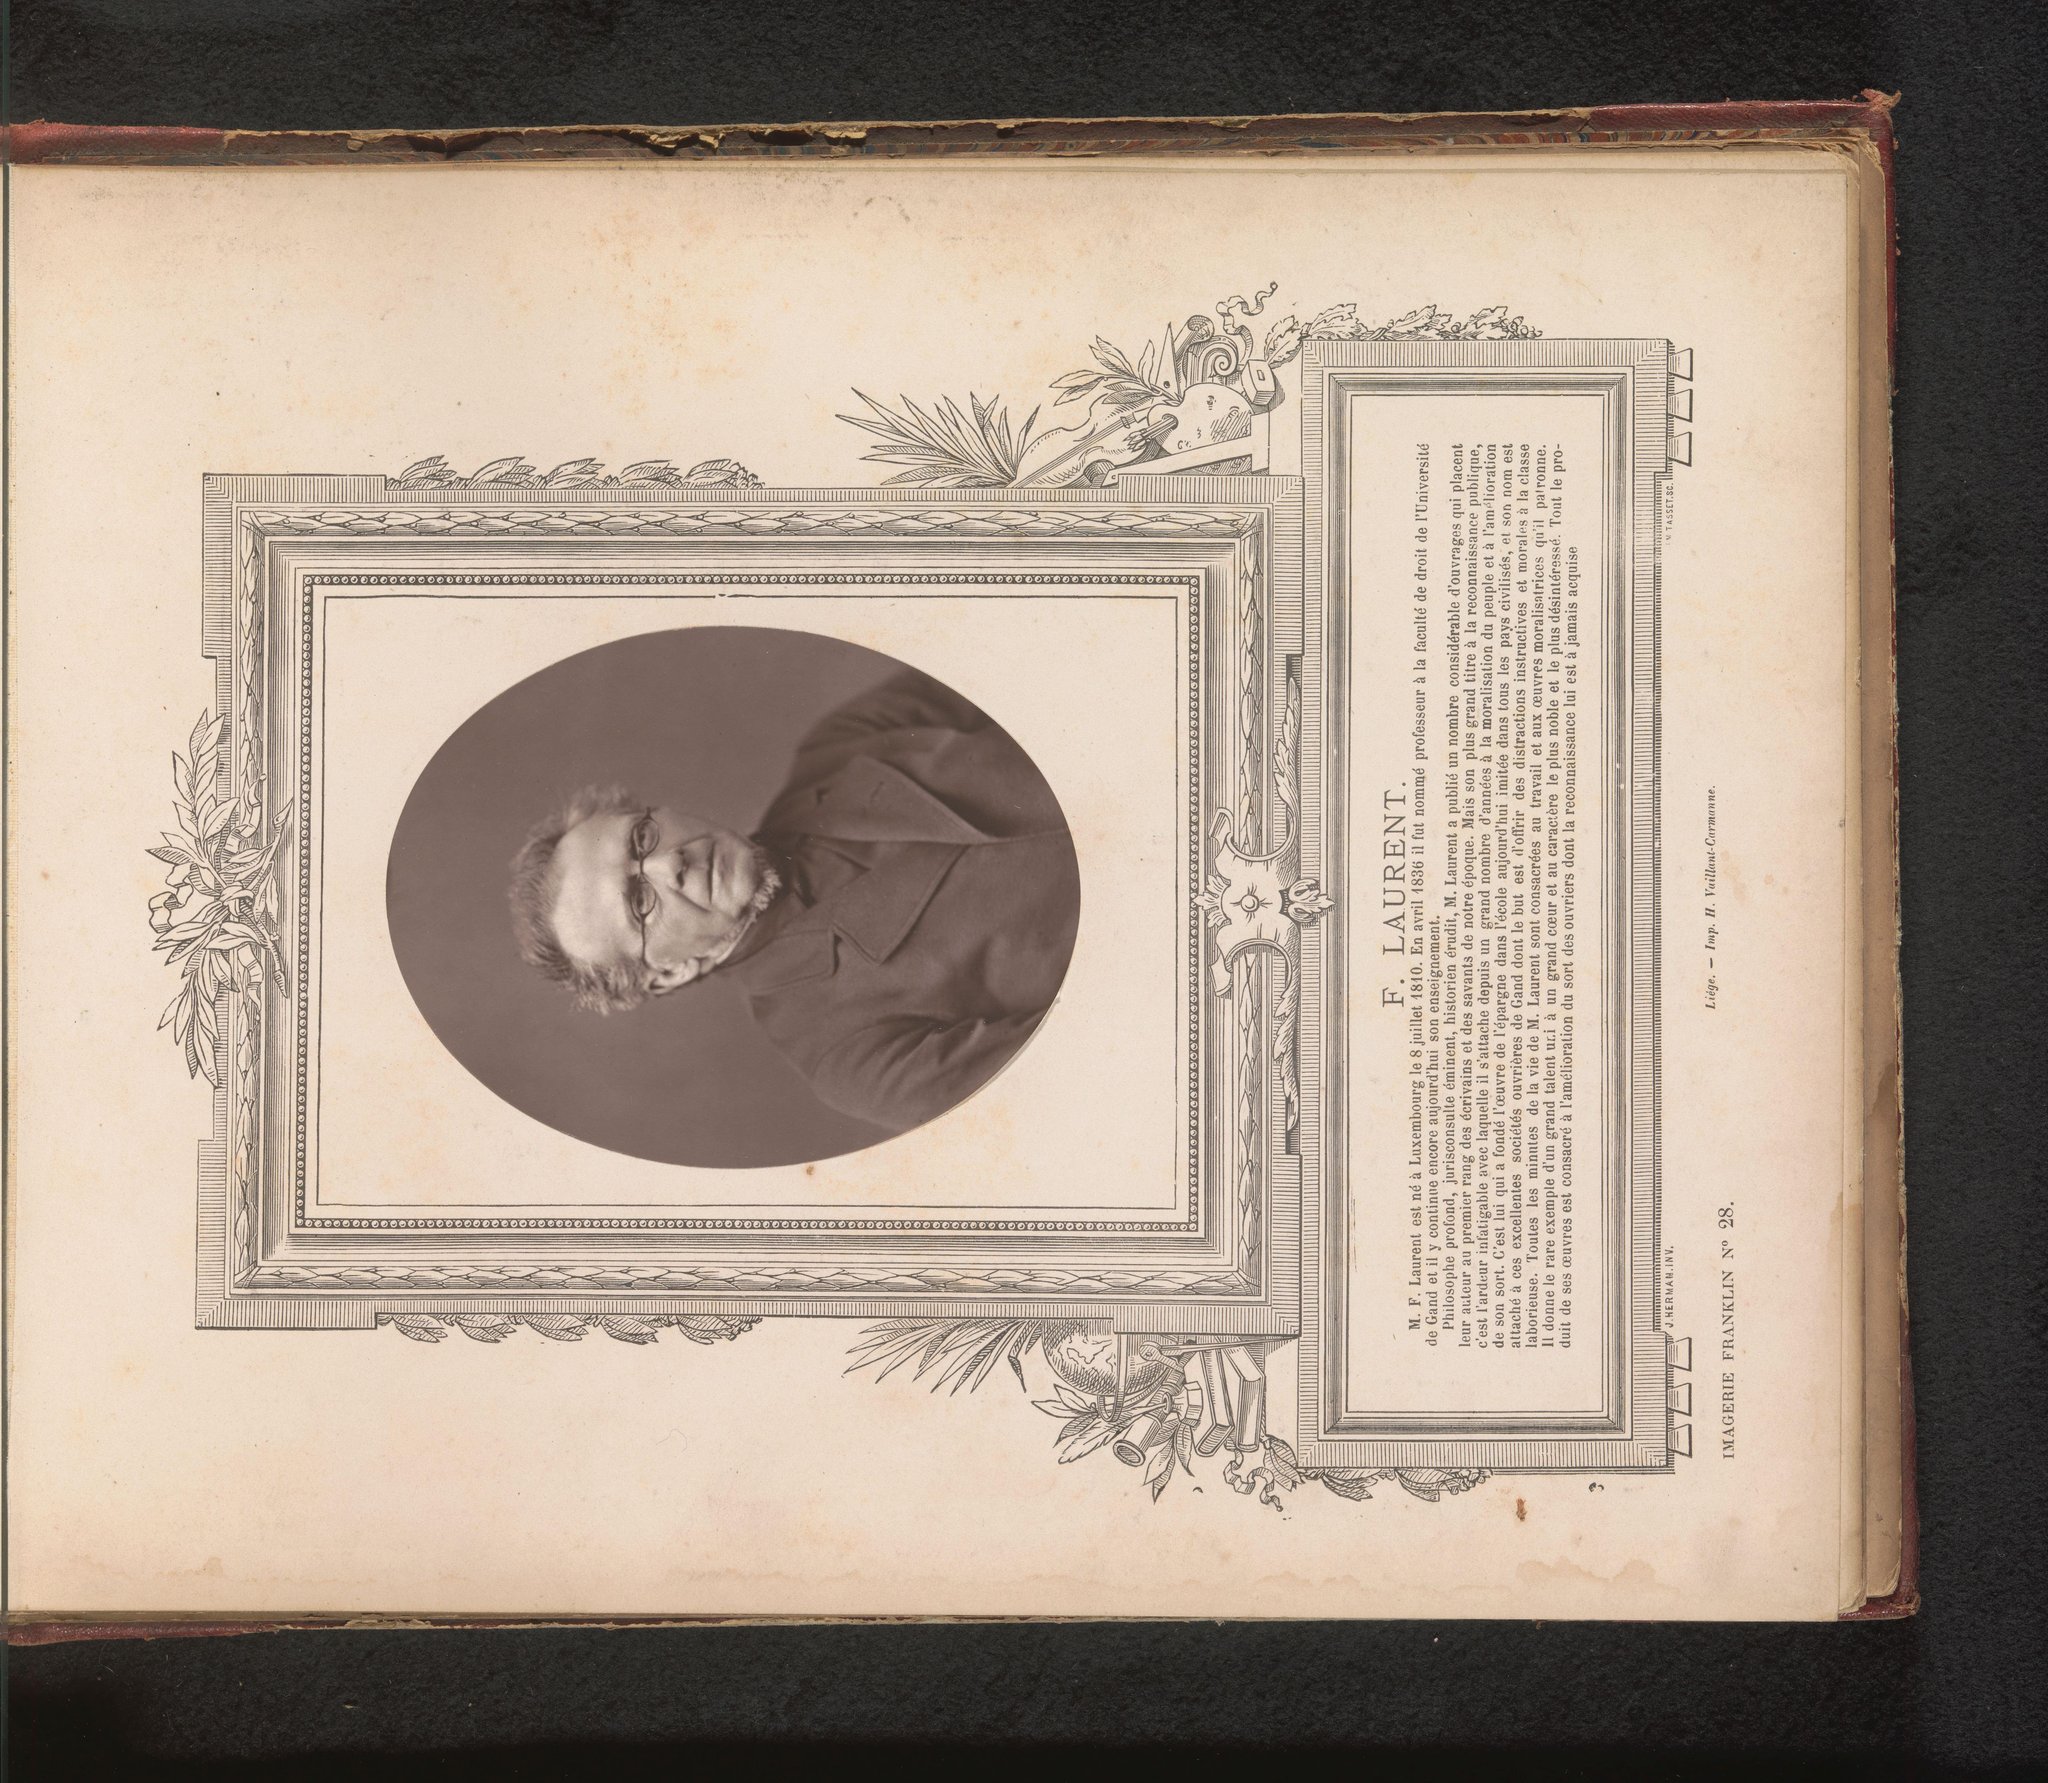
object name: page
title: Portret van François Laurent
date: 1871-1880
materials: paper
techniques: woodburytype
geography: liège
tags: ghent, historical persons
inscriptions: inscription: ‘IMAGERIE FRANKLIN No 28. -1879.’, inscription: ‘M. F. Laurent (...) jamais acquise’, name: ‘EM. TASSET, SC.’, name: ‘J. HERMAN, INV.’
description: Deze prent maakt deel uit van een album.